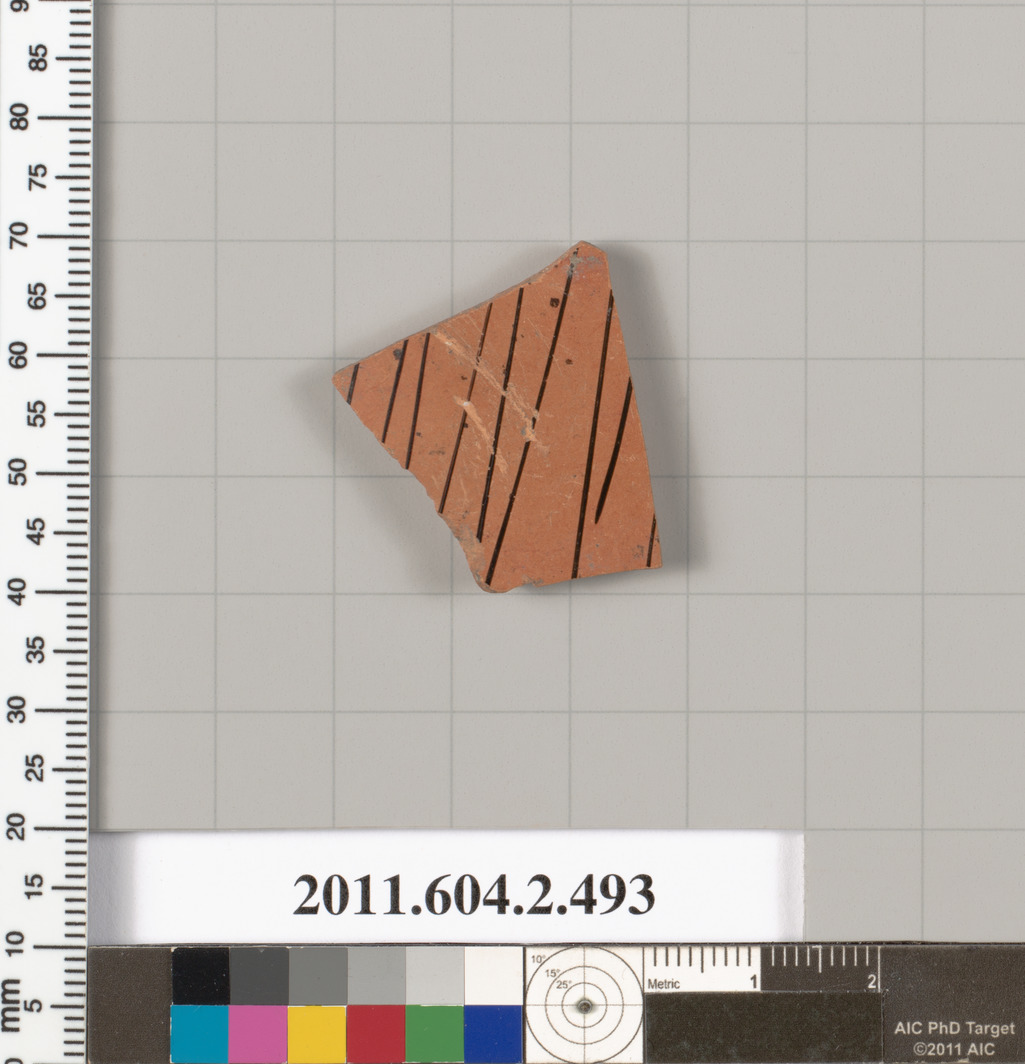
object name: column krater fragment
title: Terracotta fragment of a column-krater (bowl for mixing wine and water)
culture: greek, attic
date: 460-440 BCE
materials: terracotta